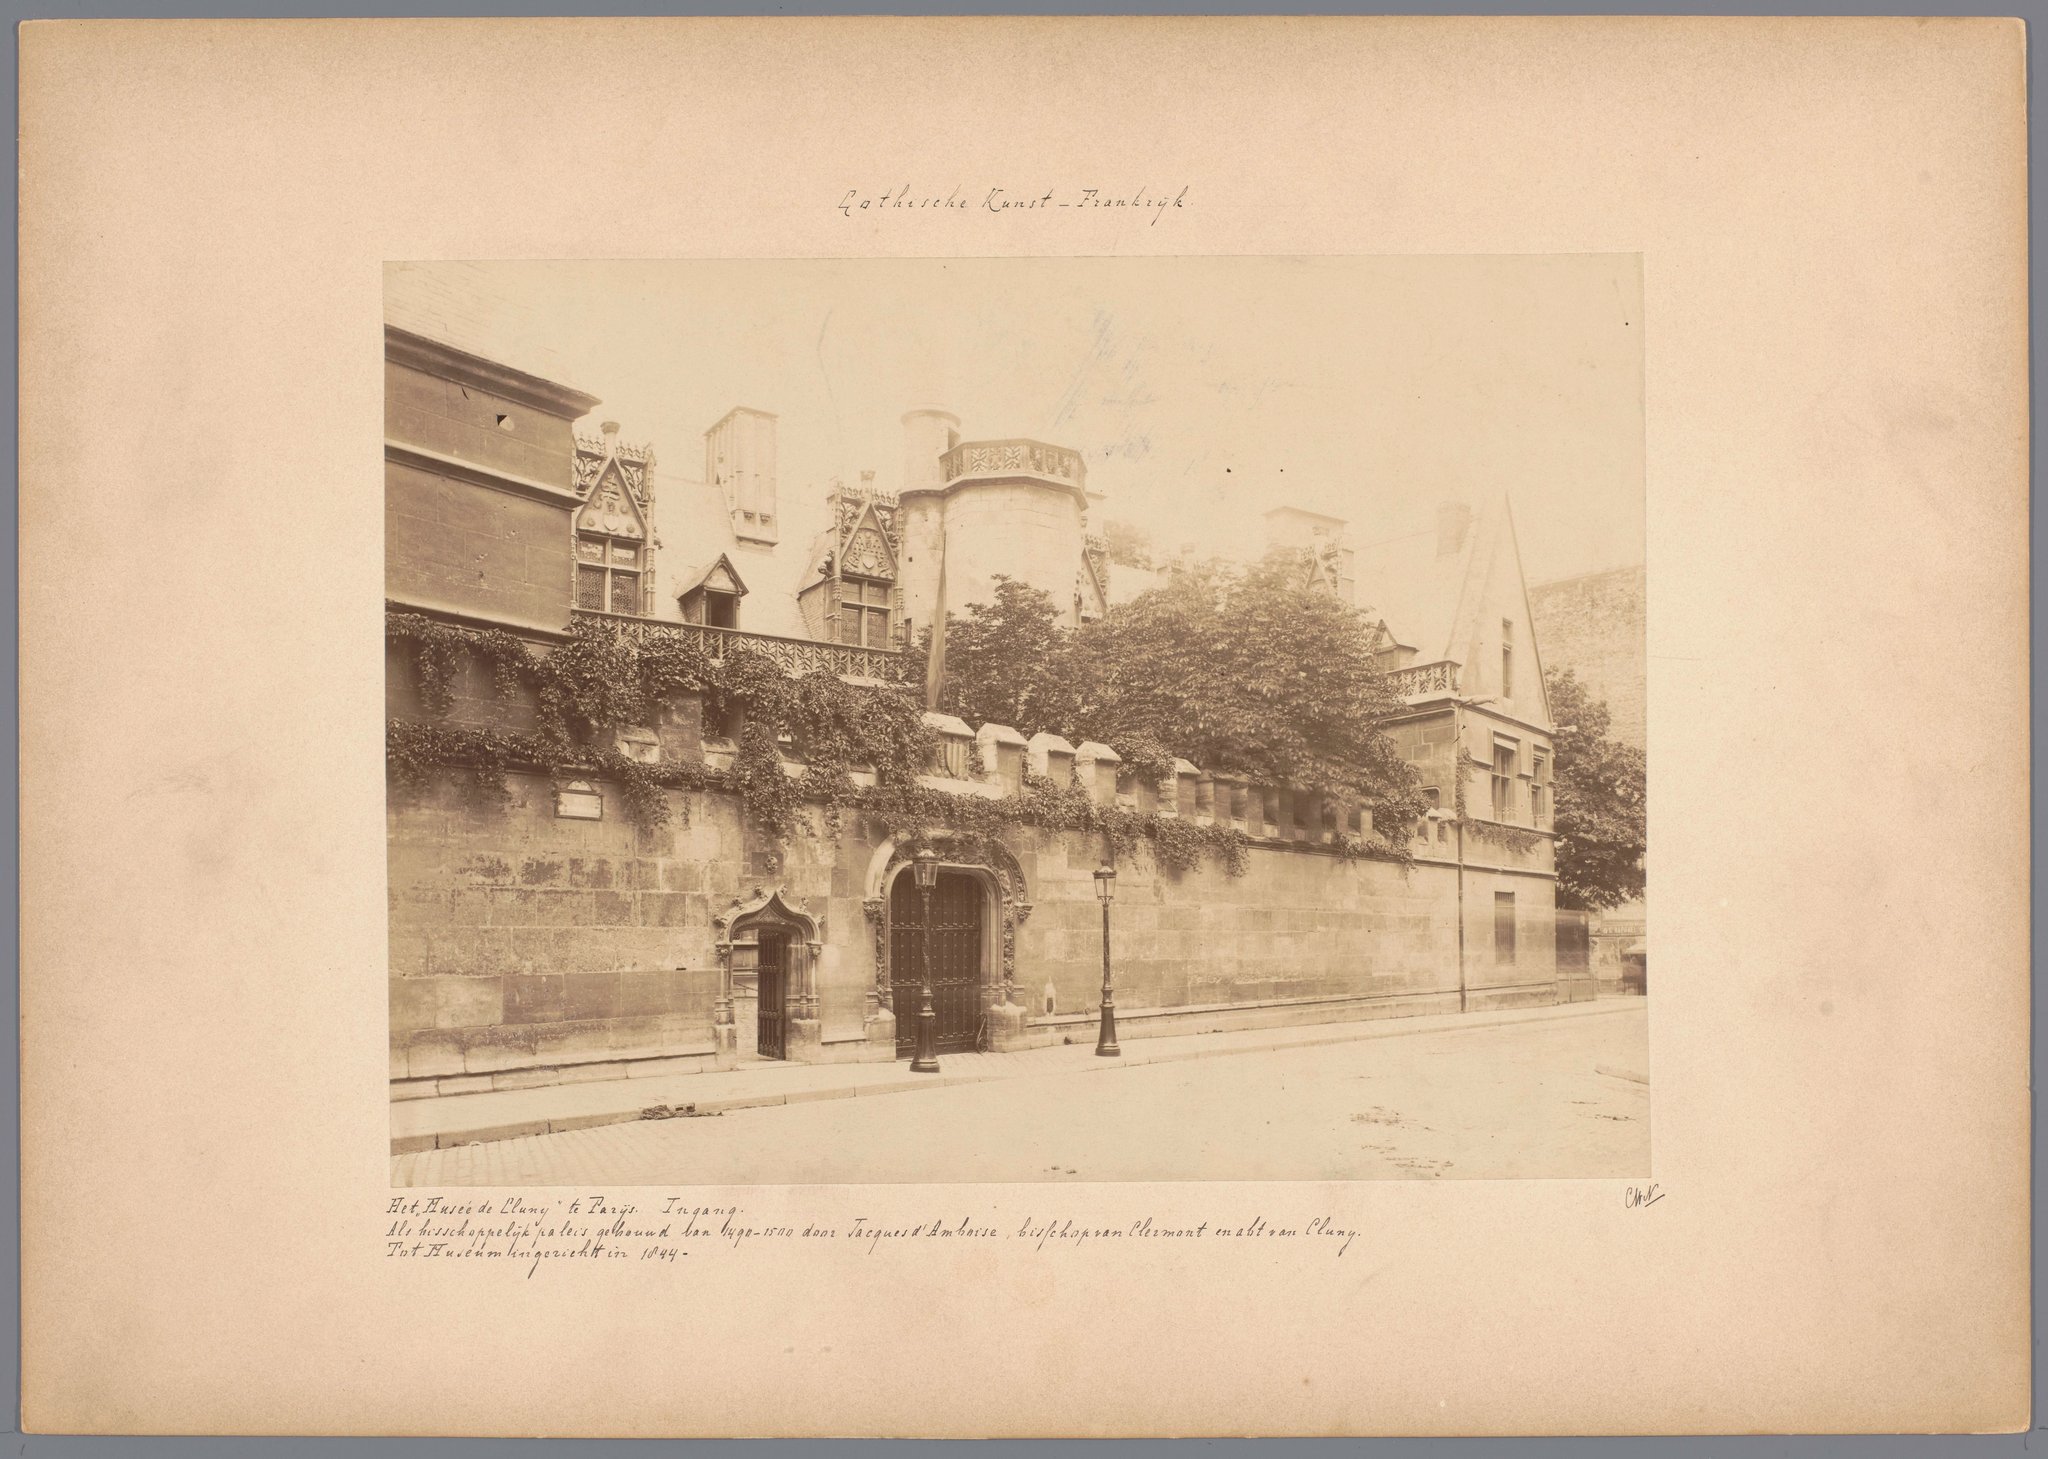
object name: photograph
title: Gevel van het Musée de Cluny te Parijs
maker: paul robert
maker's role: fotograaf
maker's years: 1865-1905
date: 1875-1900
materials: cardboard, photographic support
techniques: albumen print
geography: paris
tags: fenced or walled garden; 'hortus conclusus', façade (of house or building), street, paris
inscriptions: inscription: ‘CWN.’, name: ‘PAUL ROBERT PARIS’, collector's mark: ‘INSTITUUT VOOR KUNST- NIJVERHEIDSONDERWIJS GABRIËL METSUSTRAAT No. 16. AMSTERDAM’, collector's mark: ‘KUNSTNIJVERHEIDSCHOOL QUELLINUS AMSTERDAM FRANS HALSSTRAAT 14.’, inscription: ‘Gothische Kunst - Frankrijk. Het ,,Musée de Cluny'' te Parijs (...) Tot Museum ingericht in 1844.’